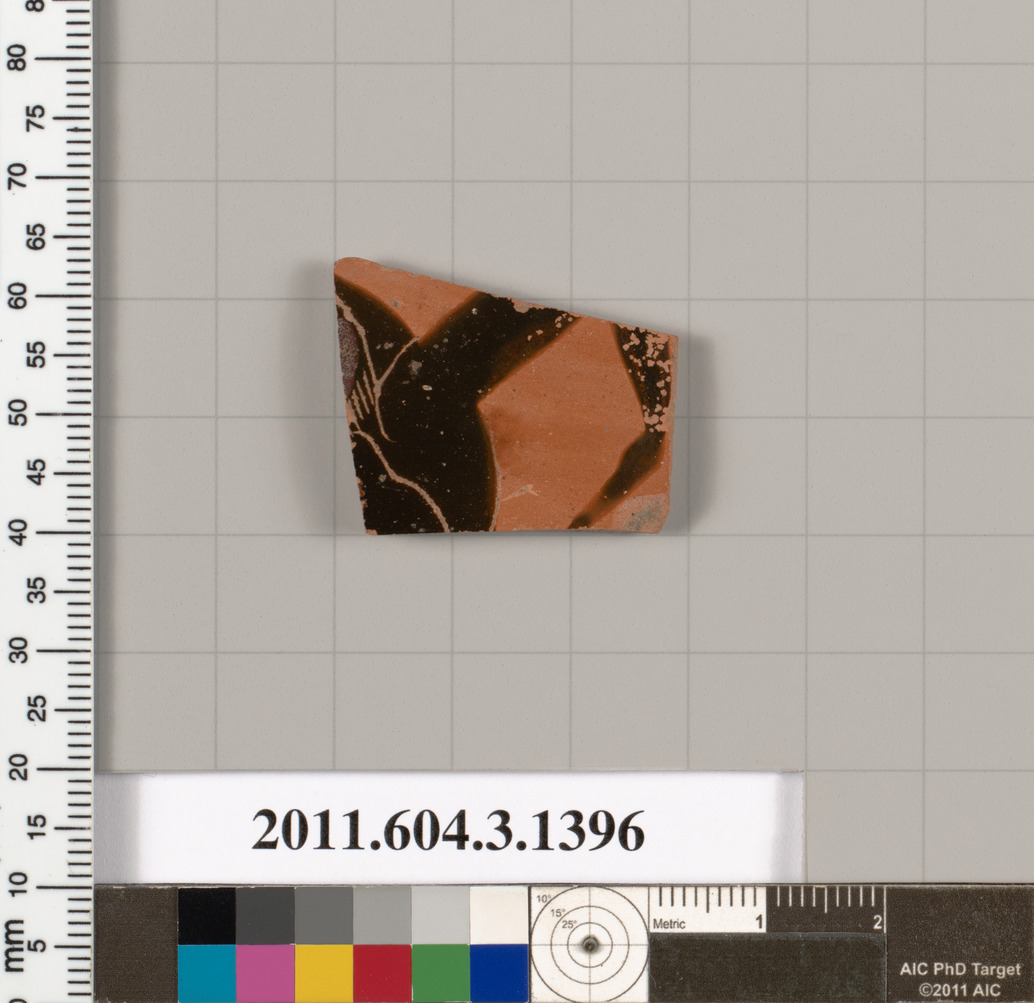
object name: skyphos fragment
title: Terracotta fragment of a skyphos (deep drinking cup)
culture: greek, attic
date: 534-468 BCE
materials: terracotta